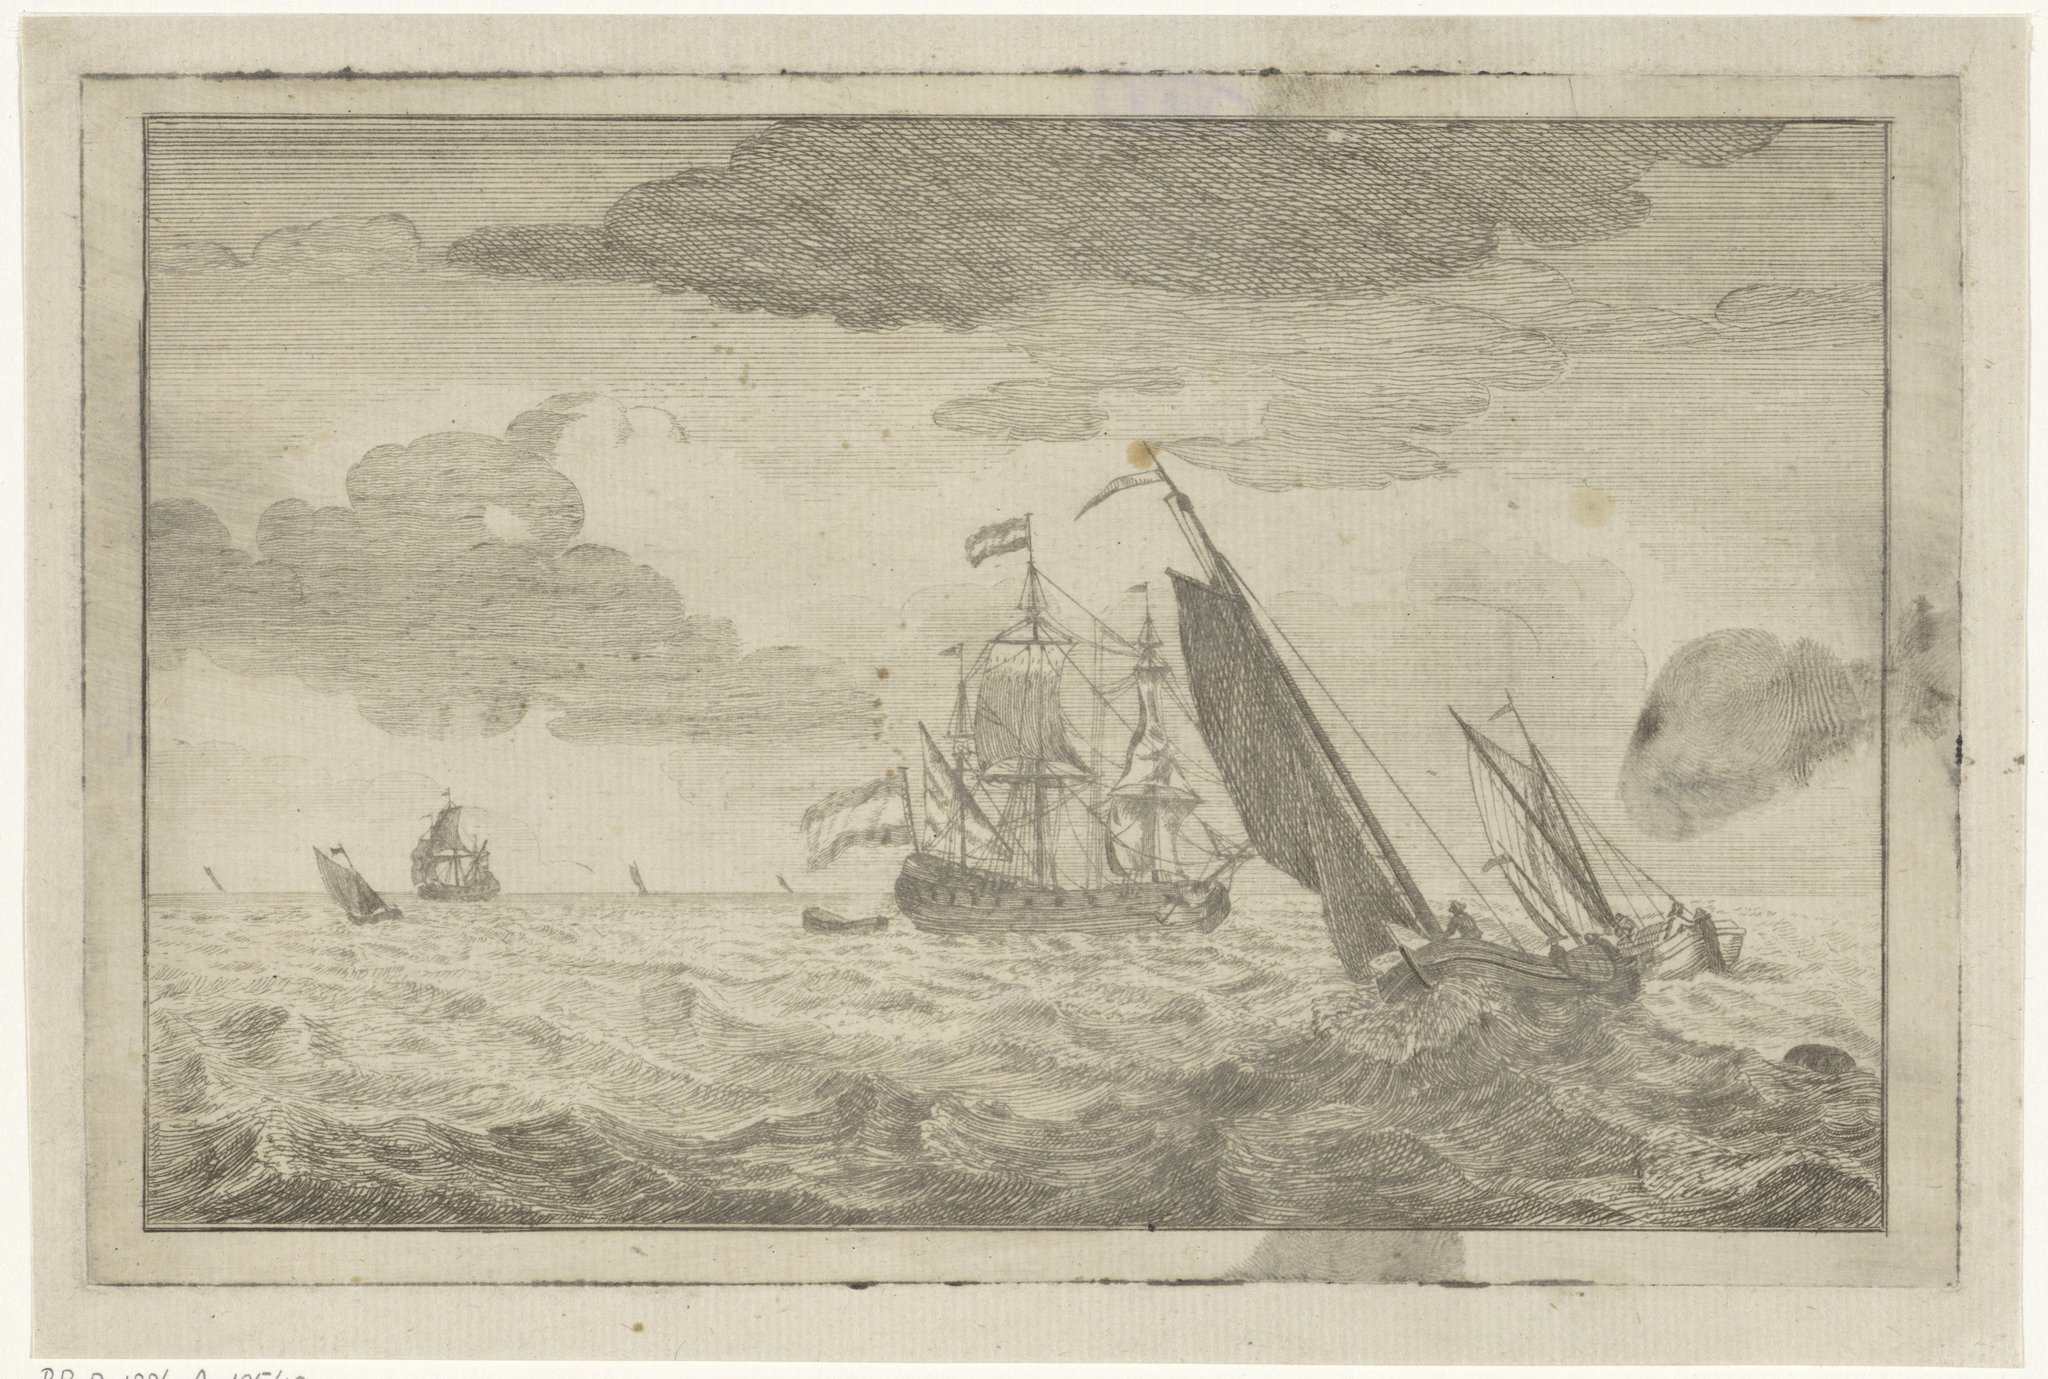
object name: print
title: Woelige zee met een driemaster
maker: adam silo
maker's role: print maker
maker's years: 1674-1760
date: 1689-1760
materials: paper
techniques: etching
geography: amsterdam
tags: sea (seascape)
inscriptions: collector's mark: Lugt 2228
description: Een driemaster met Nederlandse vlaggen ligt midden op zee. Twee vissersboten op de voorgrond hangen schuin tegen de wind. Op de achtergrond nog enkele schepen.